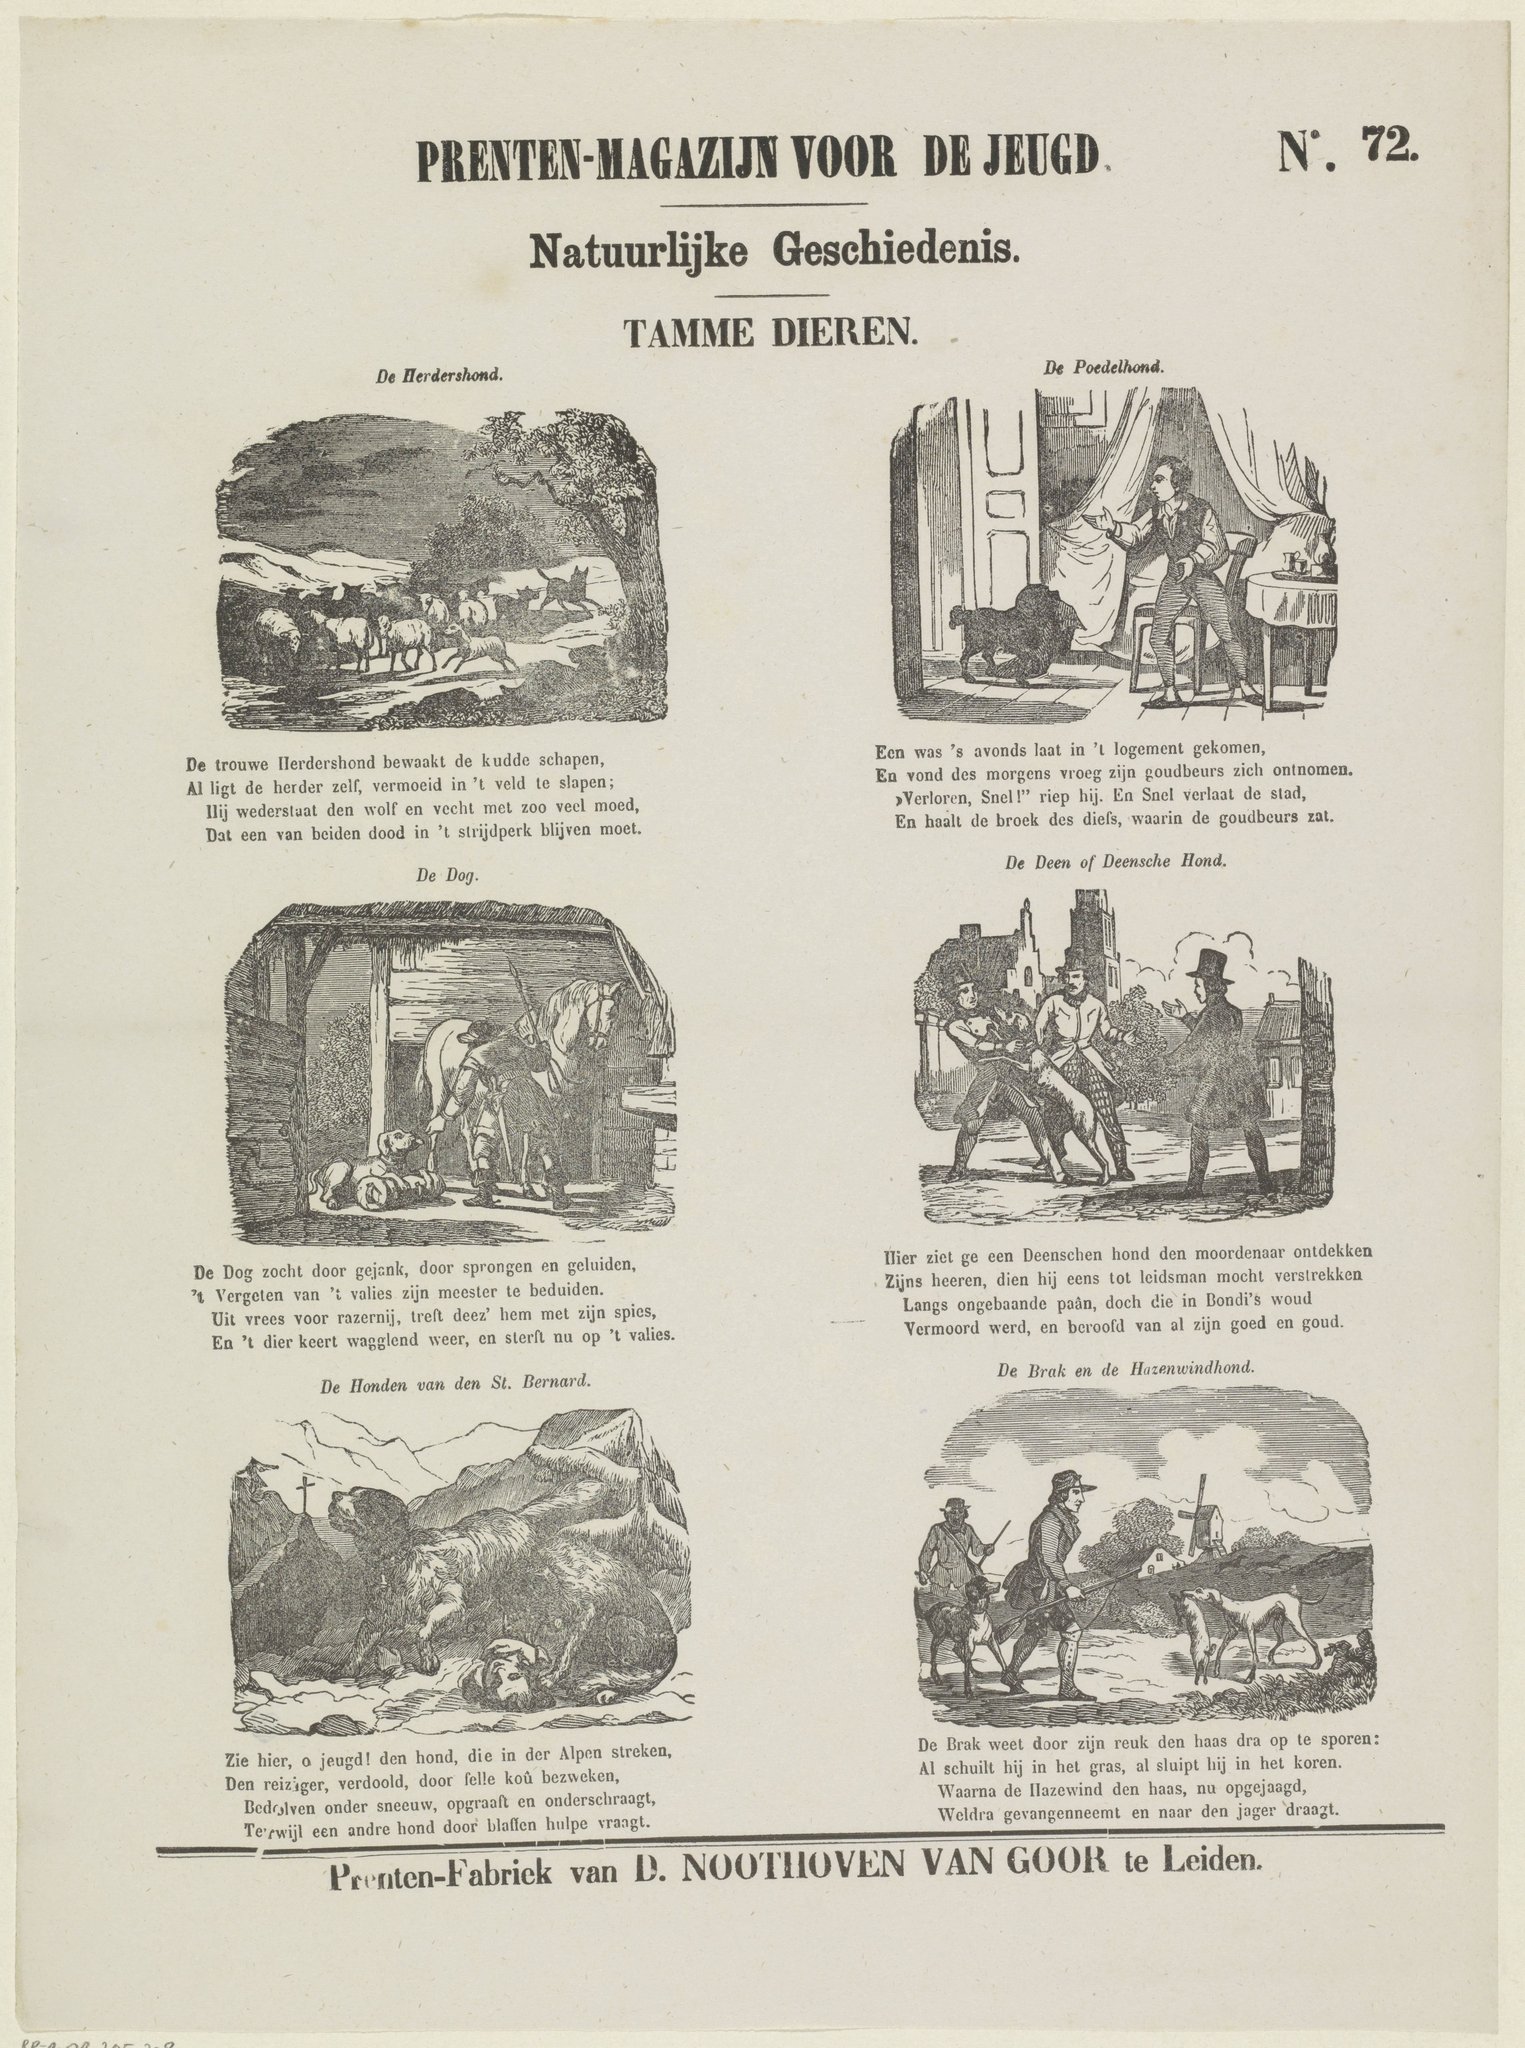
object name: print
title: Natuurlijke geschiedenis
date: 1850-1881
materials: paper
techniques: letterpress printing, engraving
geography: leiden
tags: dog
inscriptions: collector's mark: Lugt 2760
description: Blad met 6 voorstellingen van verschillende honden, zoals een herdershond, een poedel en een Sint-bernard. Boven elke voorstelling een titel en onder elke voorstelling een vierregelig vers. Genummerd rechtsboven: No. 72.